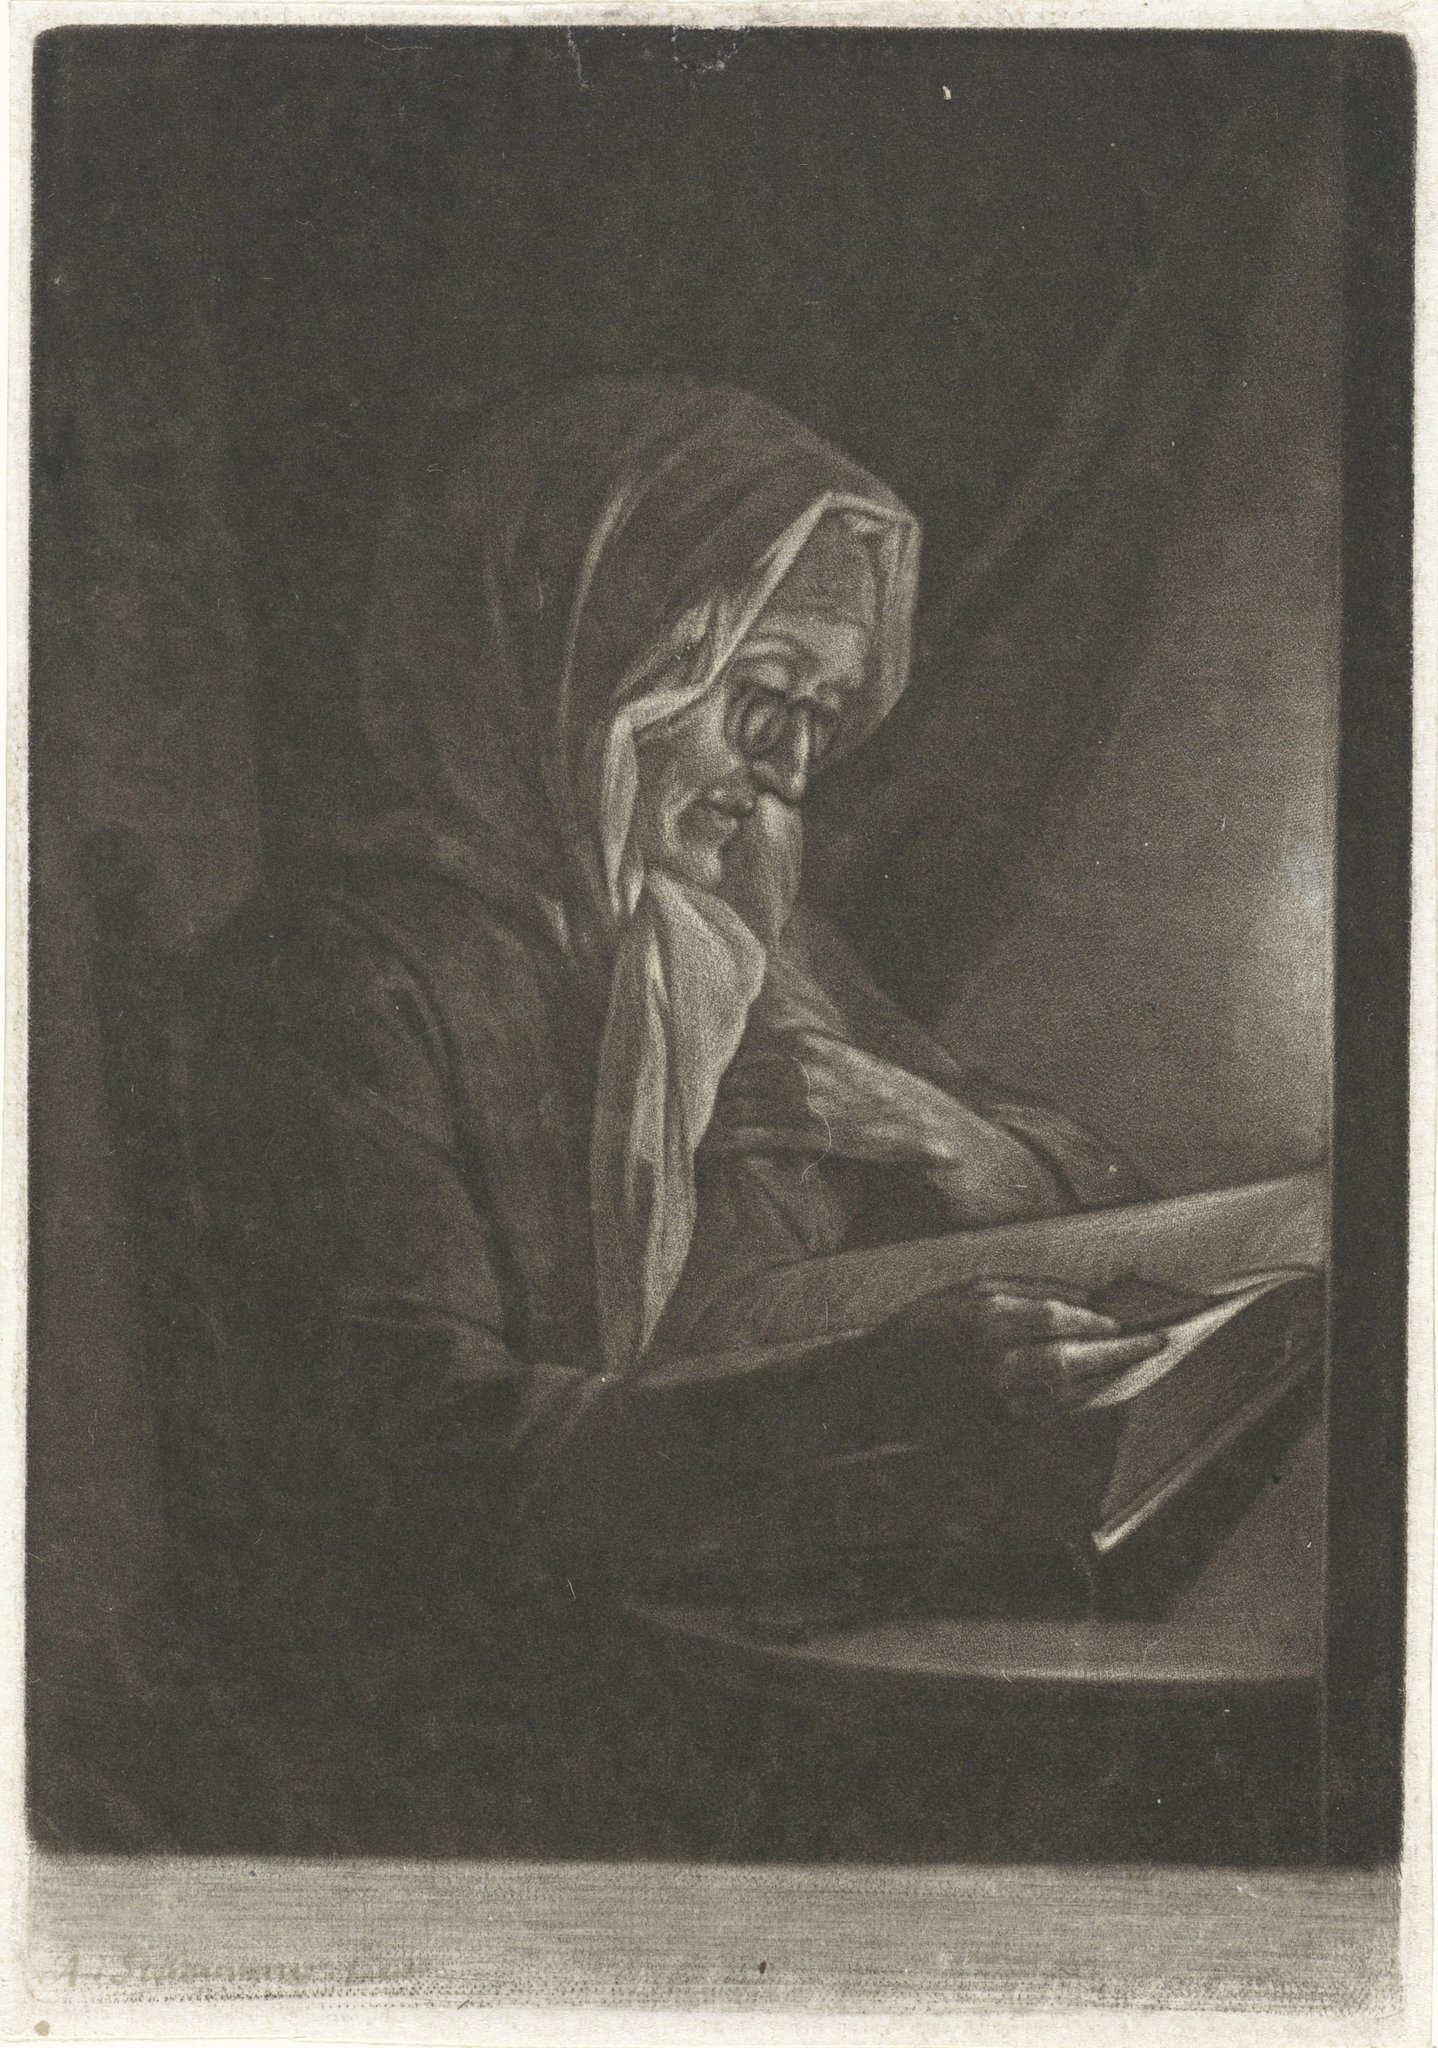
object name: print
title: Lezende vrouw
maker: aert schouman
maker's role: draughtsman, painter, print maker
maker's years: 1710-1792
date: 1720-1792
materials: paper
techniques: mezzotint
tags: eyeglasses, spectacles, reading, book - mm - book open, candle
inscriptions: collector's mark: Lugt 2228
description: Een oude vrouw leest een boek bij kaarslicht. Ze draagt een bril.